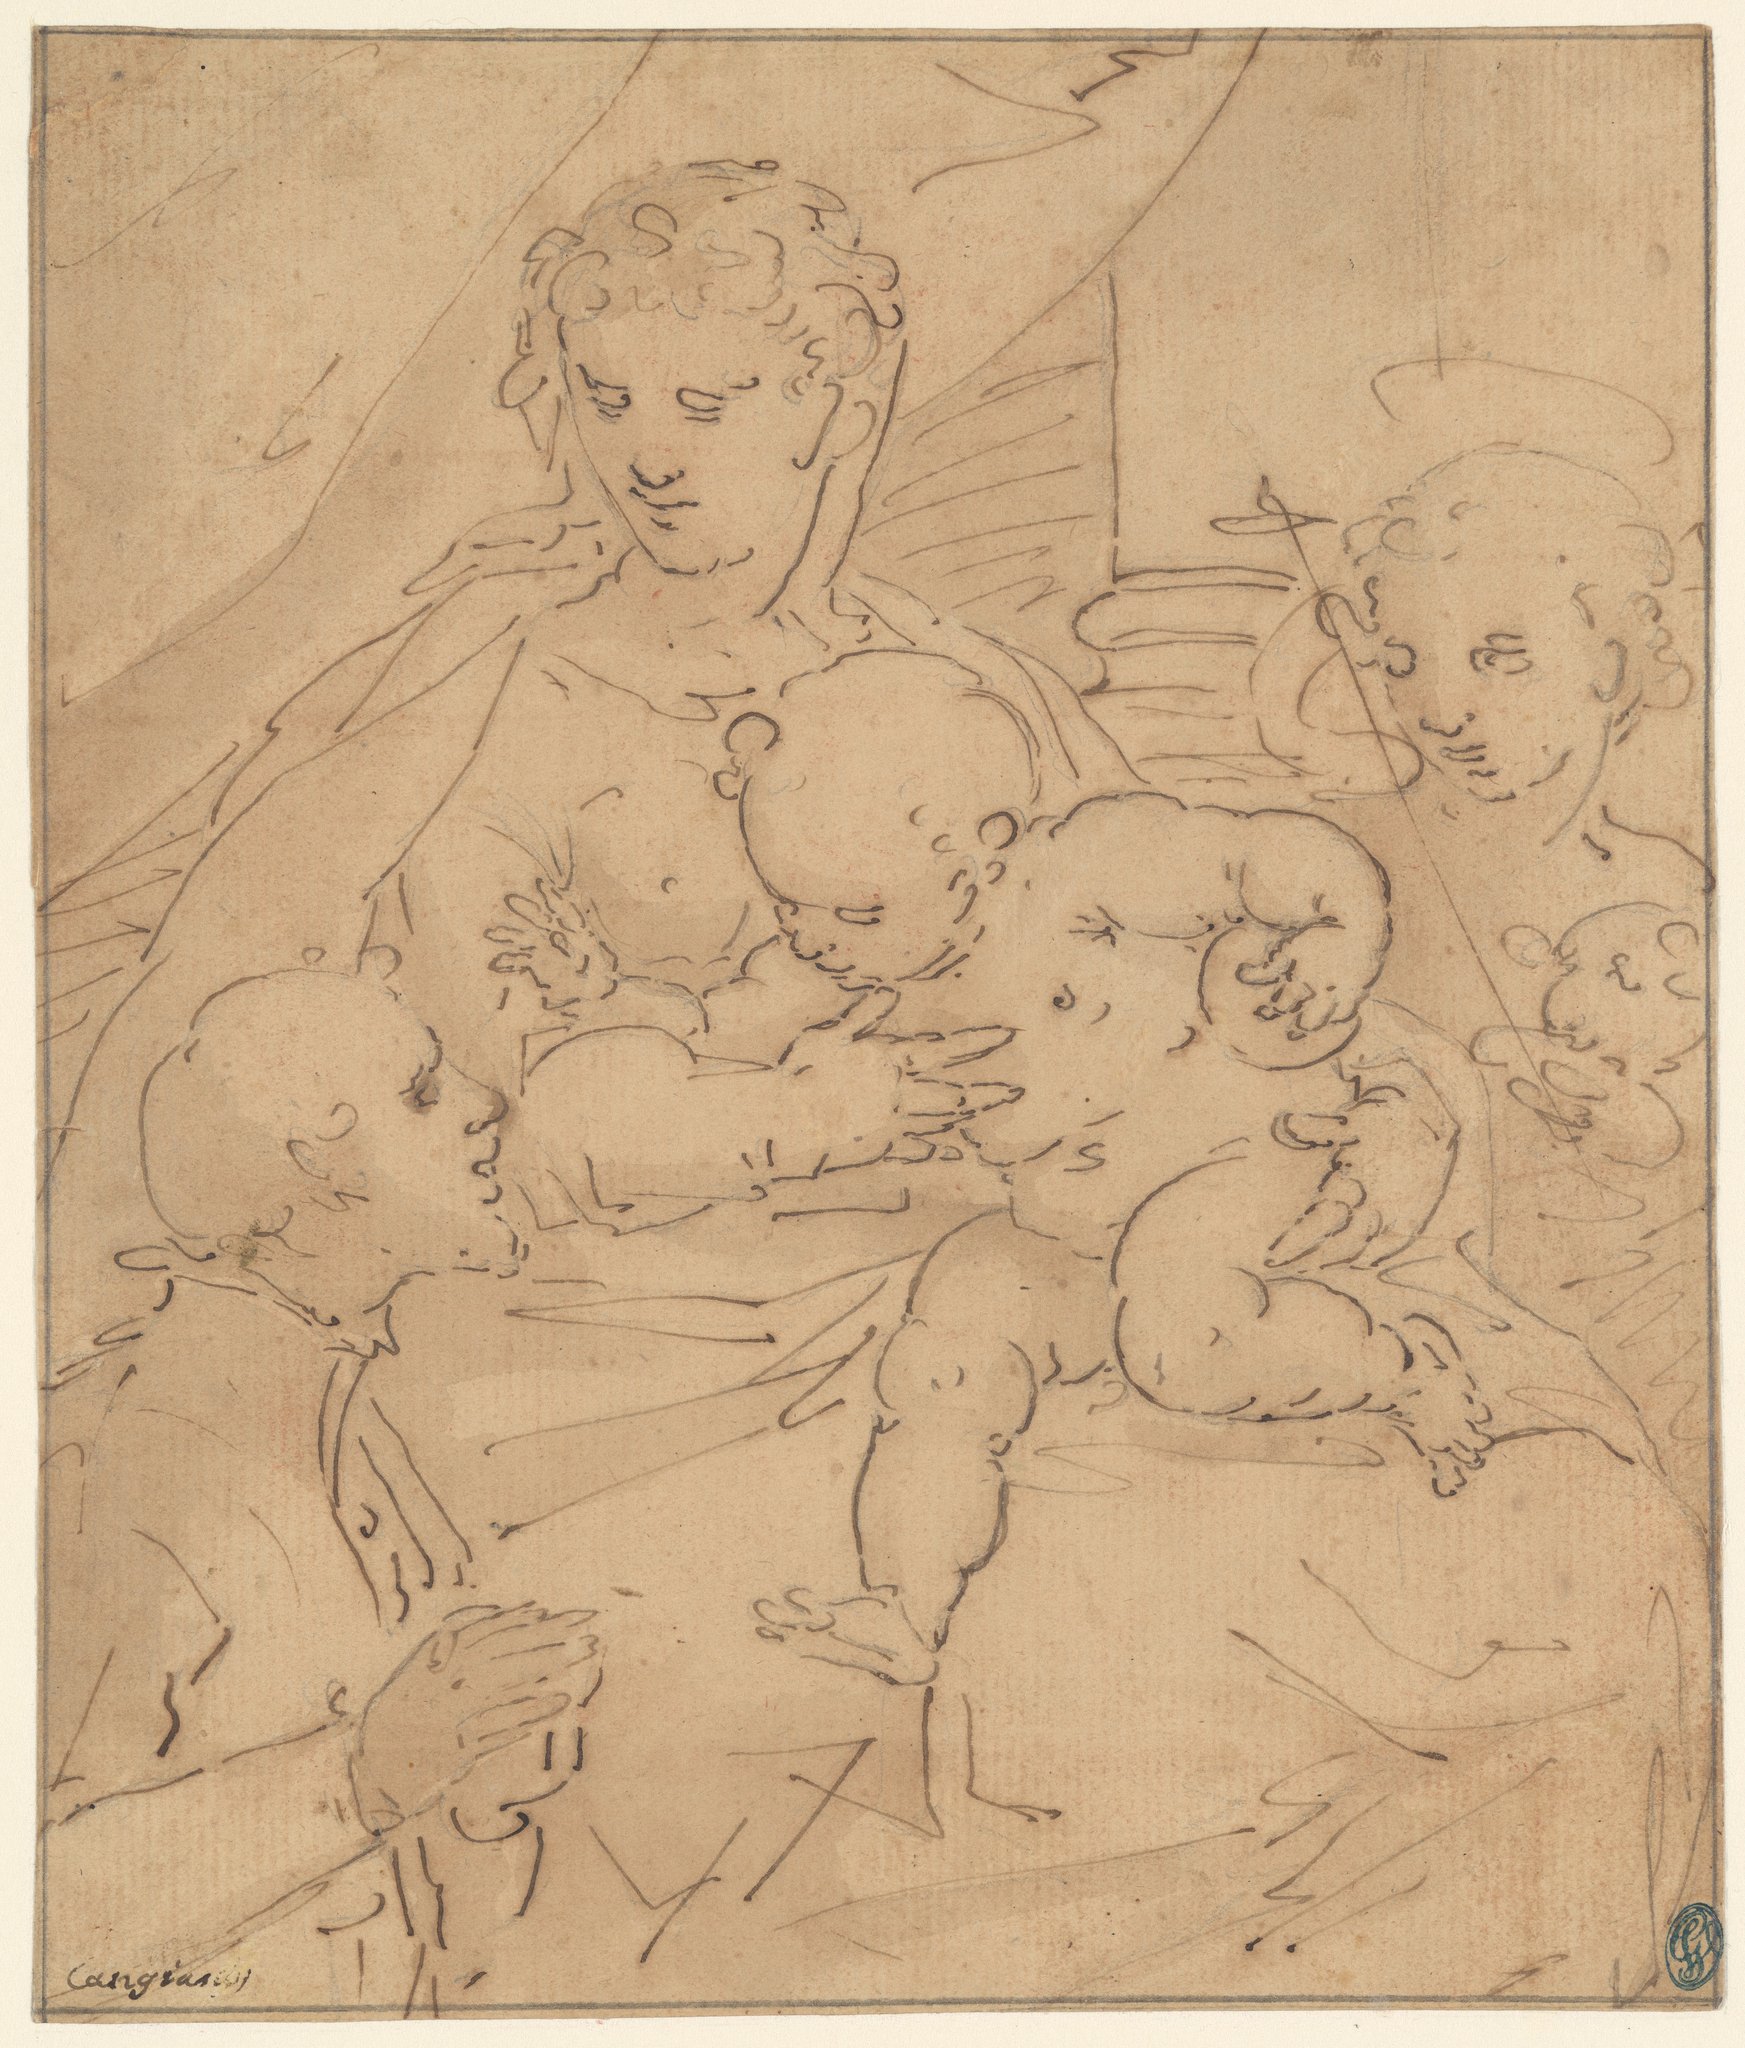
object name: drawing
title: Madonna and Child with the Young Saint John the Baptist and a Donor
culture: italian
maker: workshop of cambiaso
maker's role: artist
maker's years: 1527-1585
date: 1560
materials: graphite, ink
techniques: pen, drawing, wash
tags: madonna and child,saint john the baptist